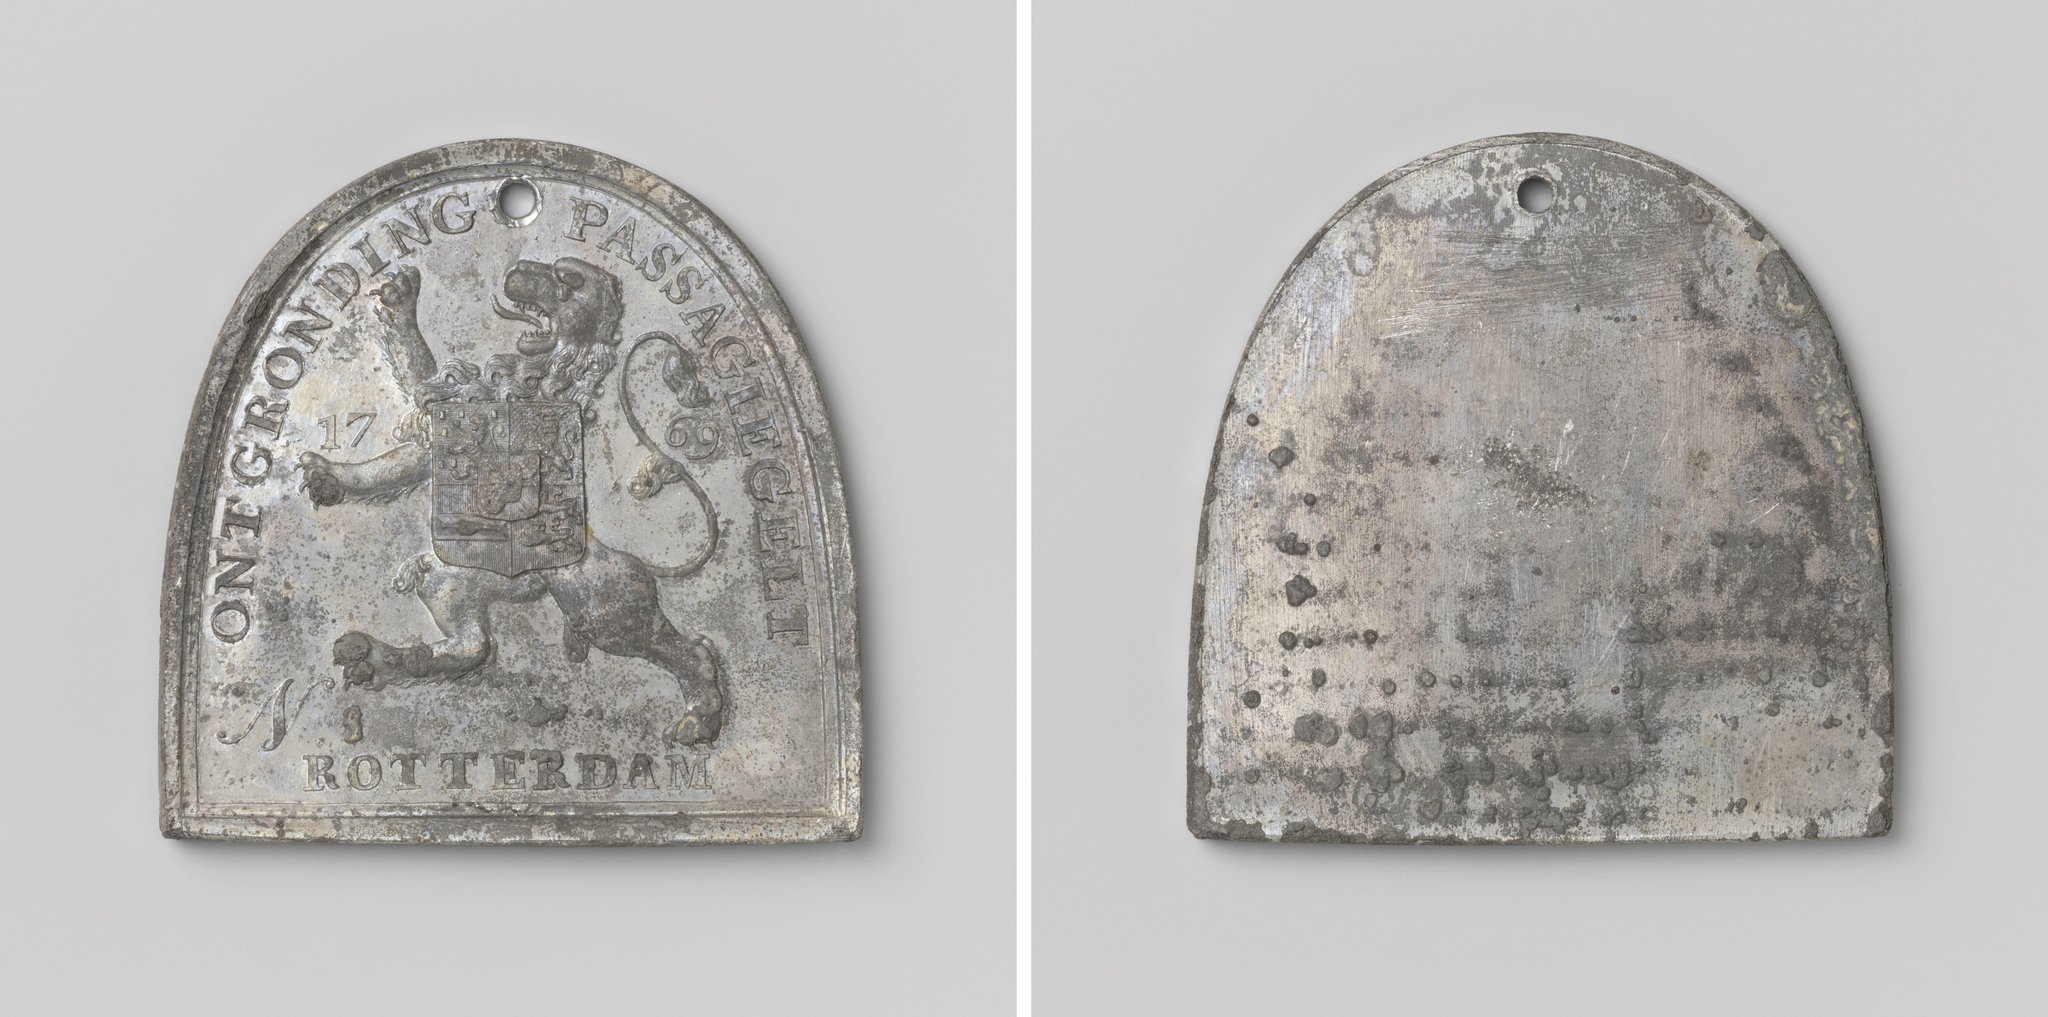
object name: identification medal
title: Ontgronding te Rotterdam, penning bedoeld als bewijs voor turfdragers, -vullers of -tonners om turf in te mogen voeren uit de nieuw ontgronde venen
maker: Anonymous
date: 1769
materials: lead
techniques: casting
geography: rotterdam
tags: rotterdam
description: Eenzijdige loden penning met ronde boven- en rechthoekige onderzijde, en gat erin. Voorzijde: staande leeuw met wapenschild op borst tussen jaartal binnen omschrift. Keerzijde: blanco.